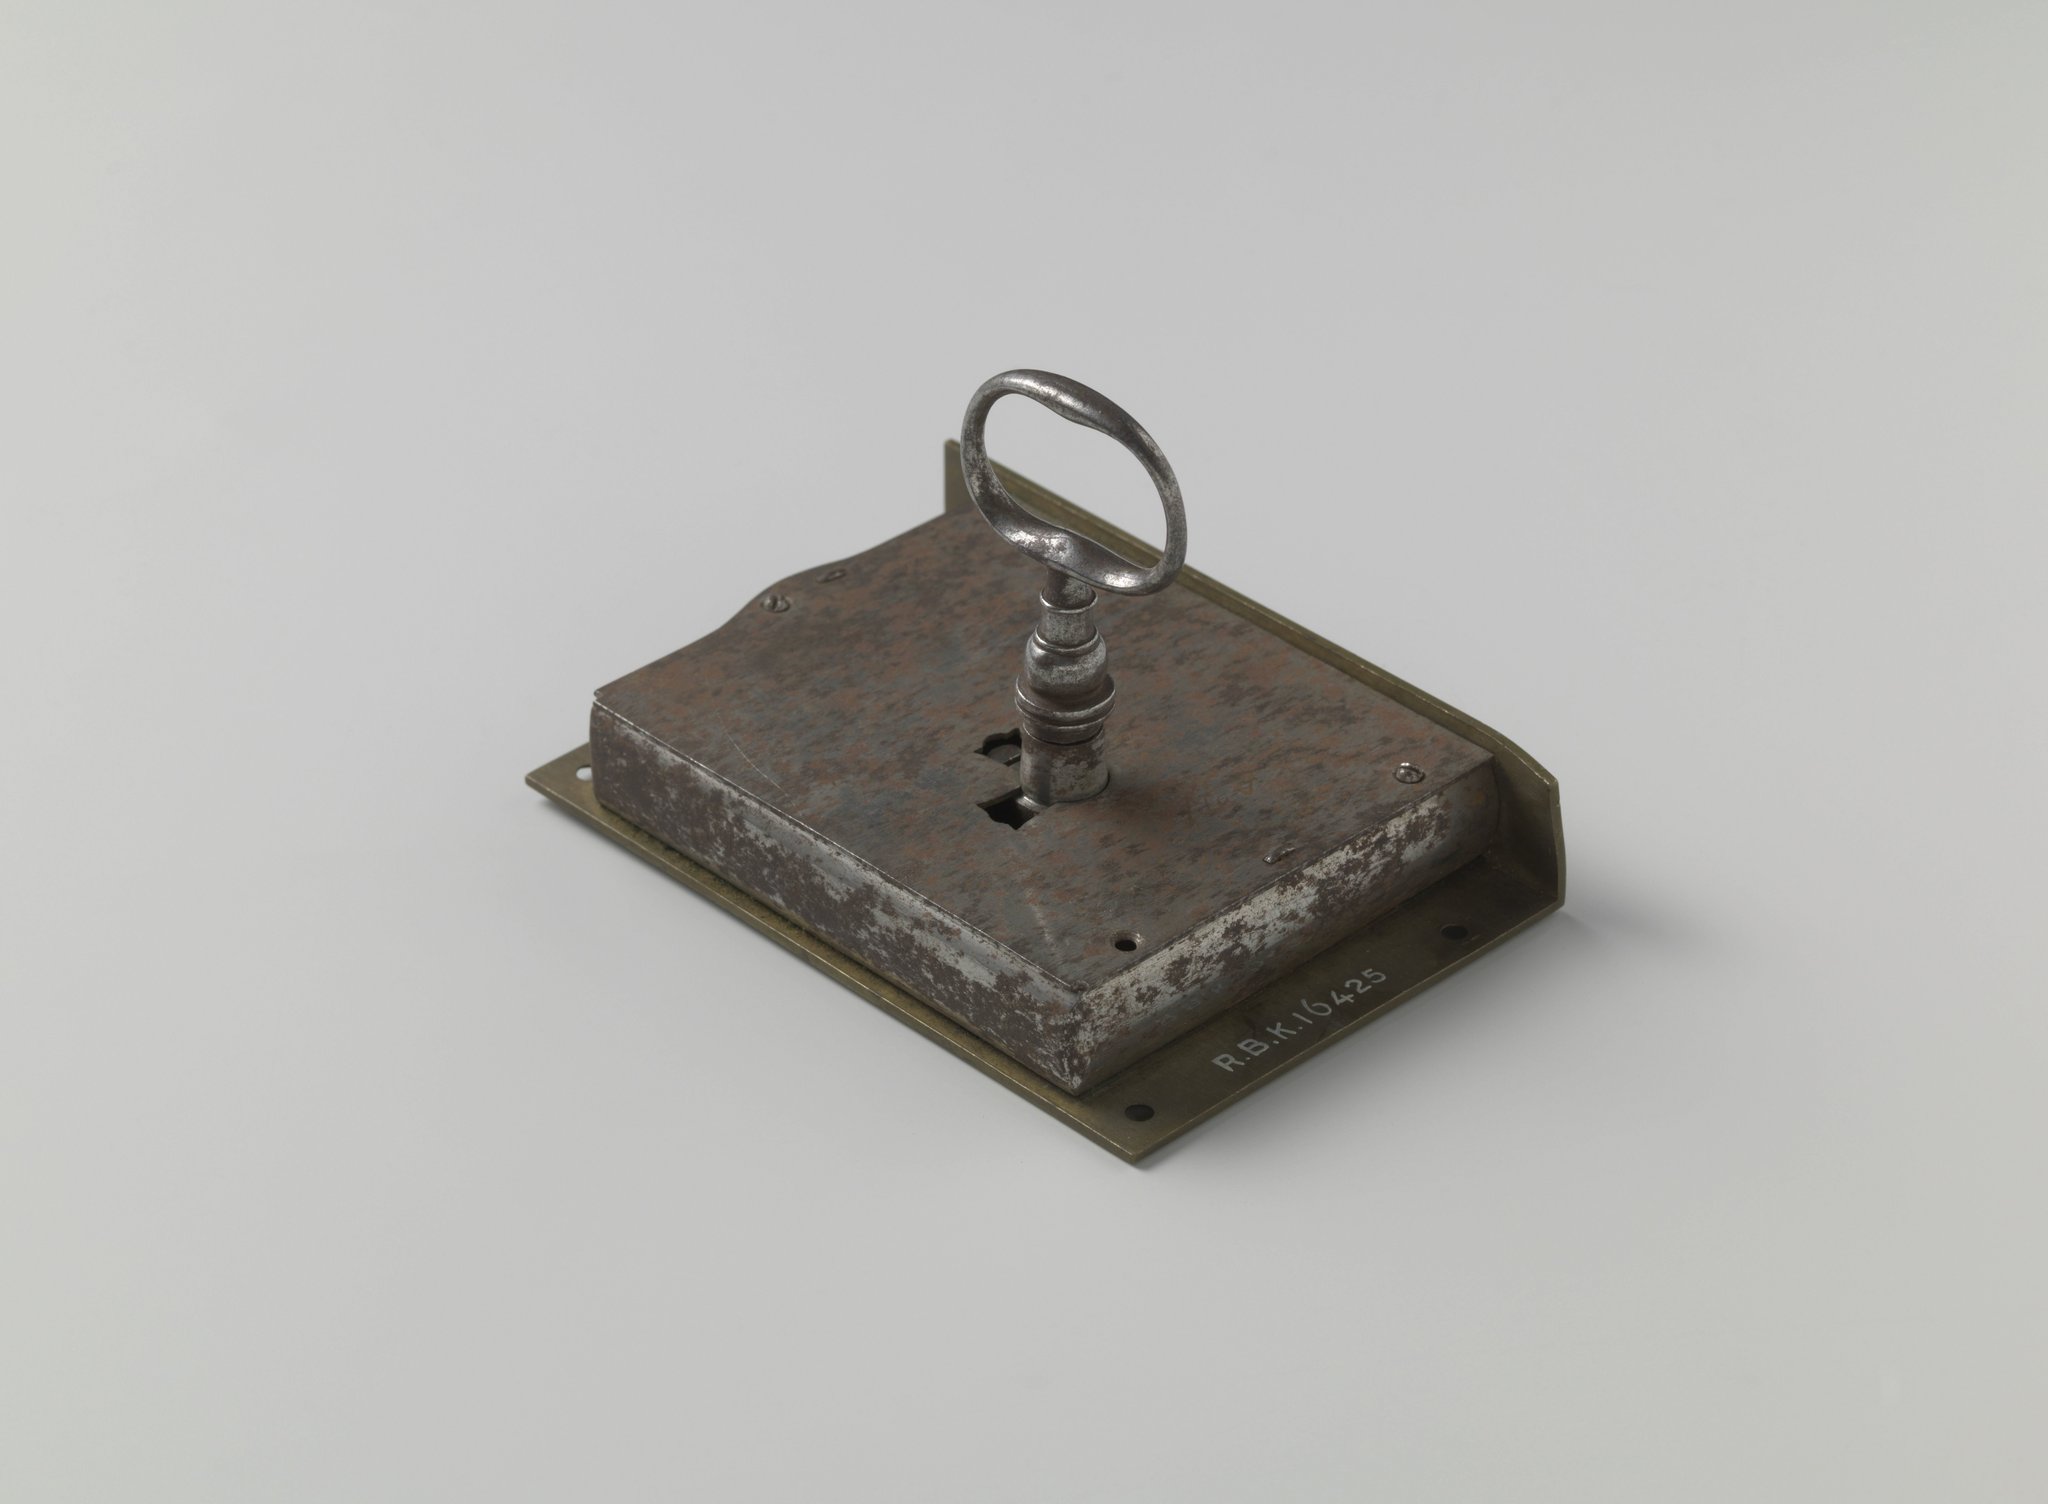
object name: key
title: Insteekslot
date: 1800-1900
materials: copper, iron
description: Een insteekslot van een meubel, tevens muziekdoos. De vierhoekige slotkast is op een iets grotere koperen montageplaat bevestigd. Twee bijbehorende sleutels met klaverbladvormige pijp en een kleine sleutel met koperen greep voor het opwinden van de muziekdoos.